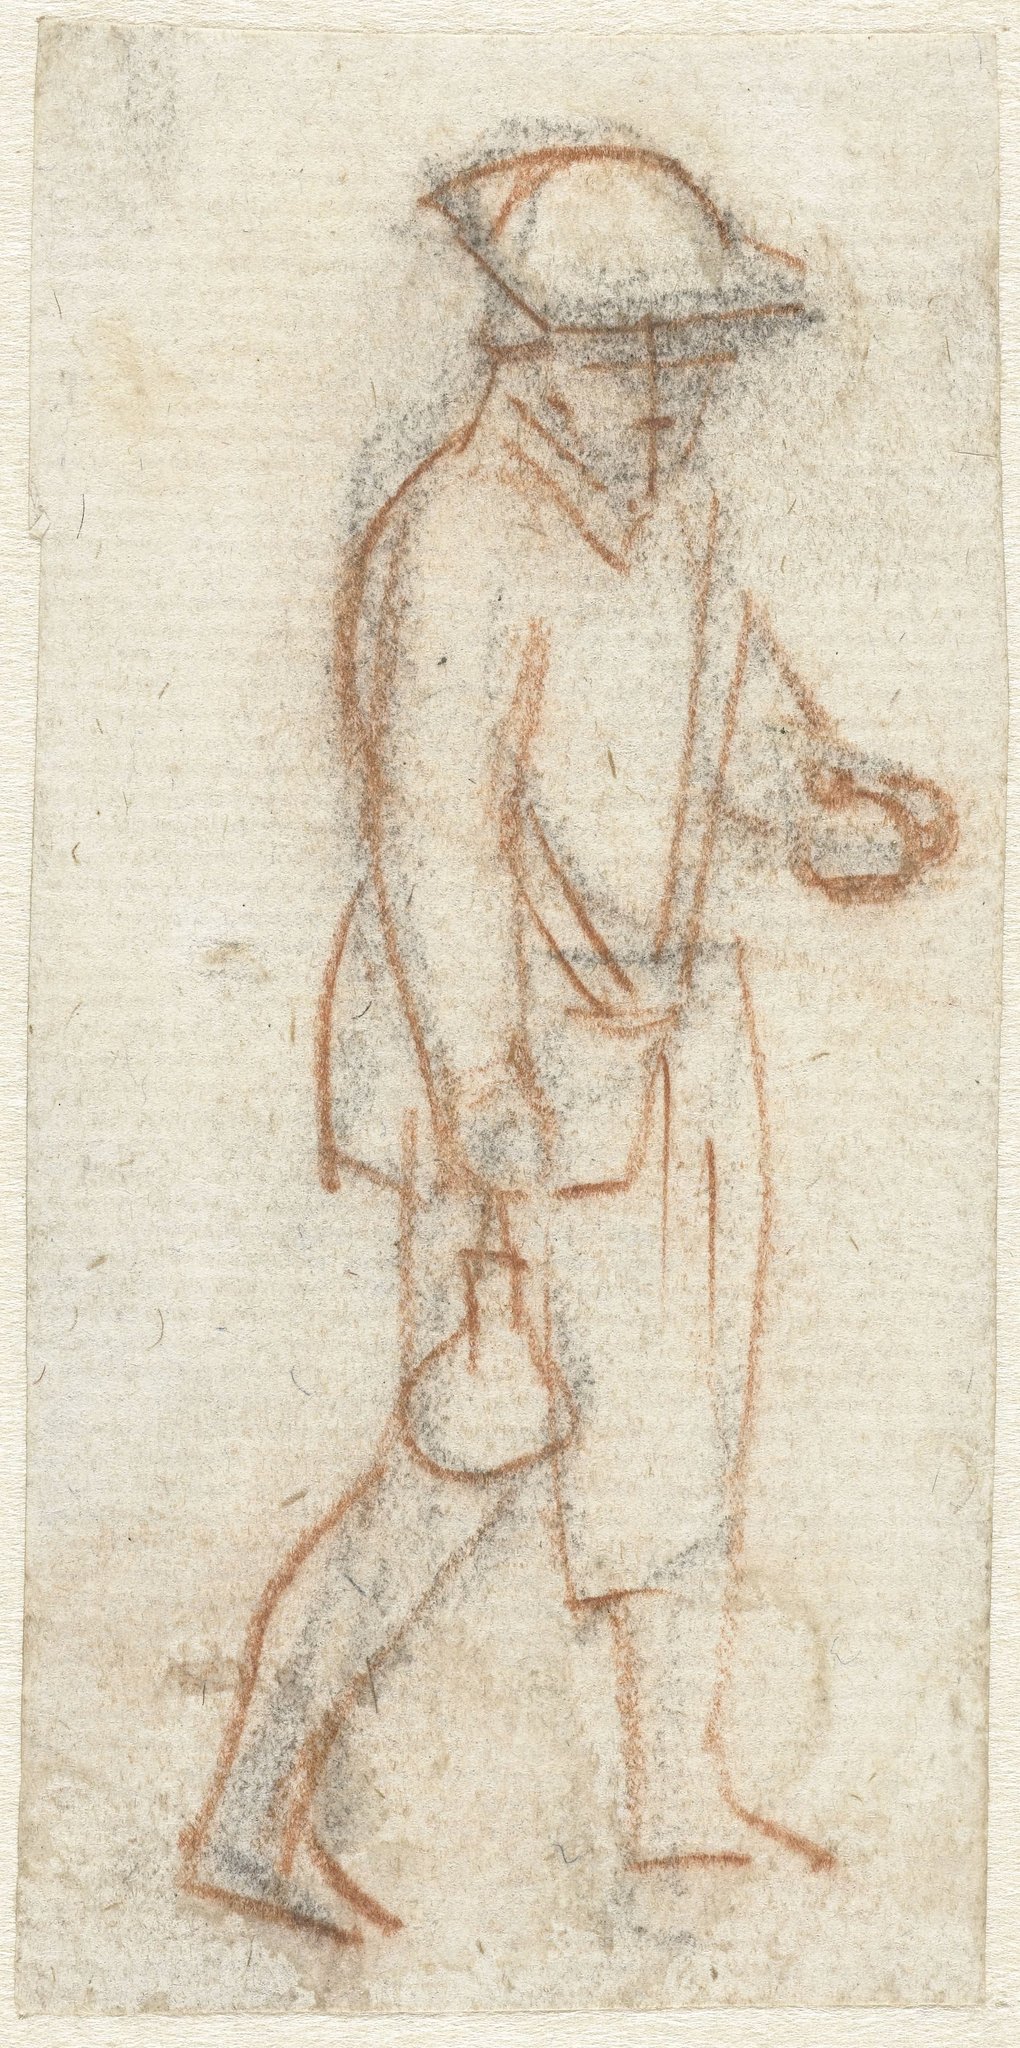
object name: drawing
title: Lopende man met een kruik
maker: simon andreas krausz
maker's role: draughtsman, print maker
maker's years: 1760-1825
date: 1770-1825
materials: chalk, paper